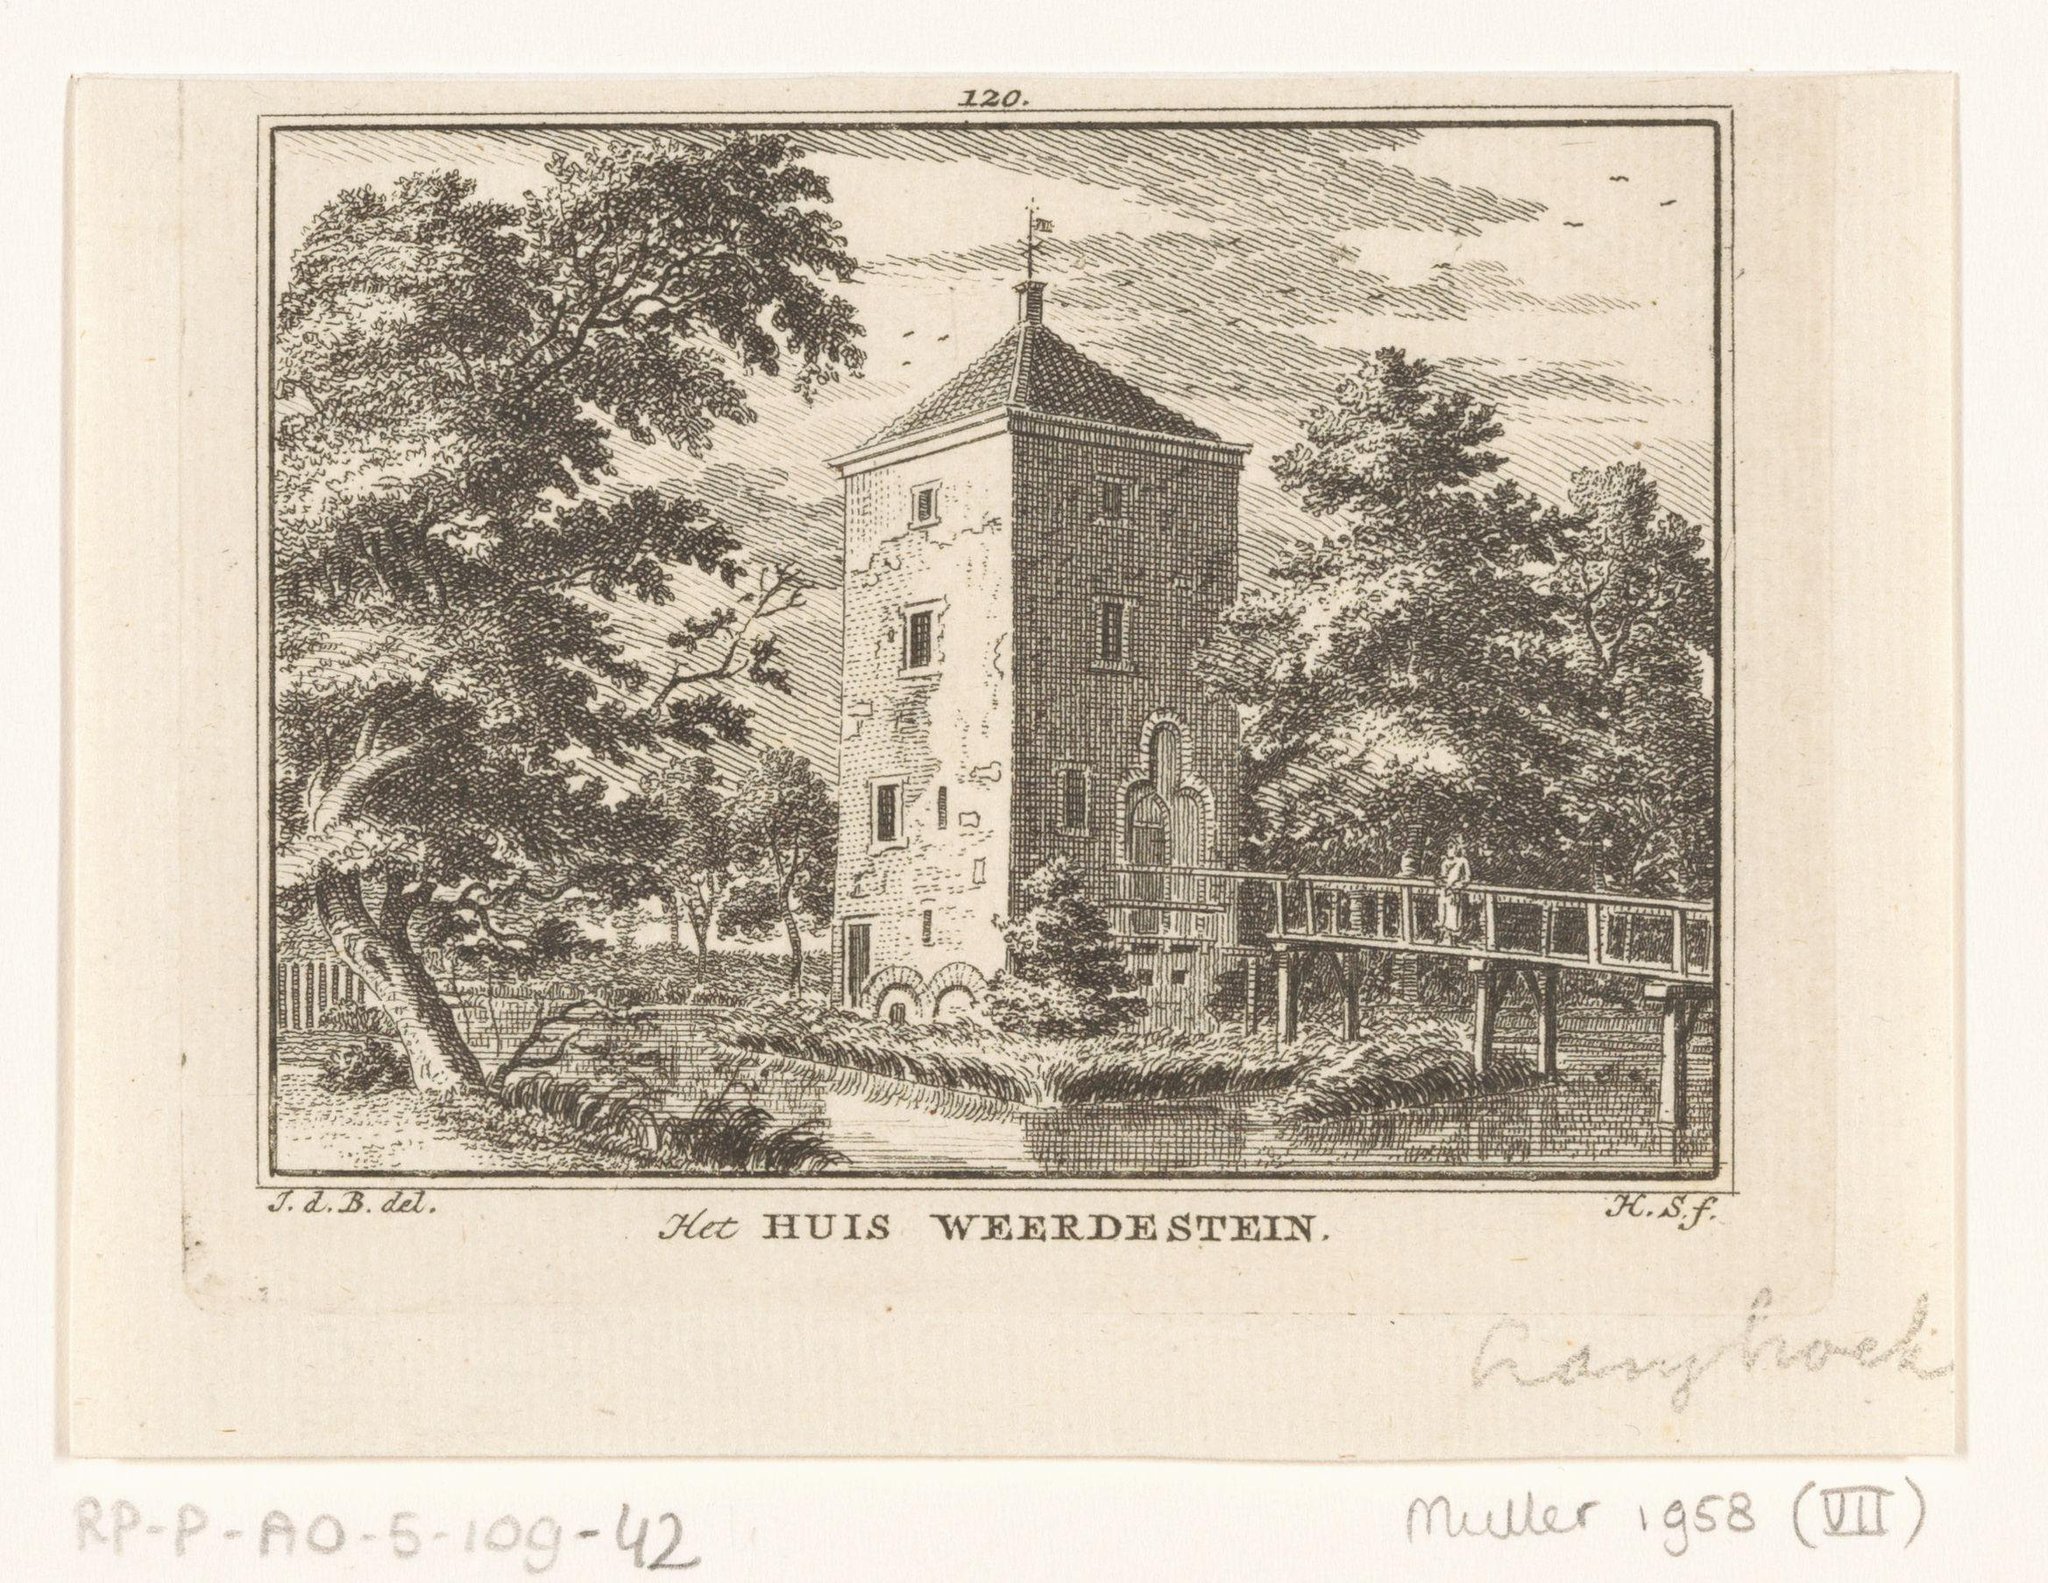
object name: book illustration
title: Het huis Weerdestein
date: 1773-1792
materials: paper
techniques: engraving, etching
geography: haarlem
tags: castle, bridge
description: Prent ook gebruikt in: Het verheerlykt Nederland of kabinet van hedendaagsche gezigten van steden, dorpen (…). 9 delen. Amsterdam: Isaak Tirion en weduwe Isaak Tirion, 1745-1774, dl. 7, 8 of 9 (weduwe Isaak Tirion, 1773-1774), ill. 120. Of in: Nederlandsche tafereelen; of eene keurige verzameling van negen honderd fraaije gezigten van steden, dorpen, sloten, oudheden (….). 9 delen. Amsterdam: Jan de Groot, 1792, dl. 7, 8 of 9, ill. 120. Uit welke druk het huidige exemplaar precies komt is niet na te gaan.